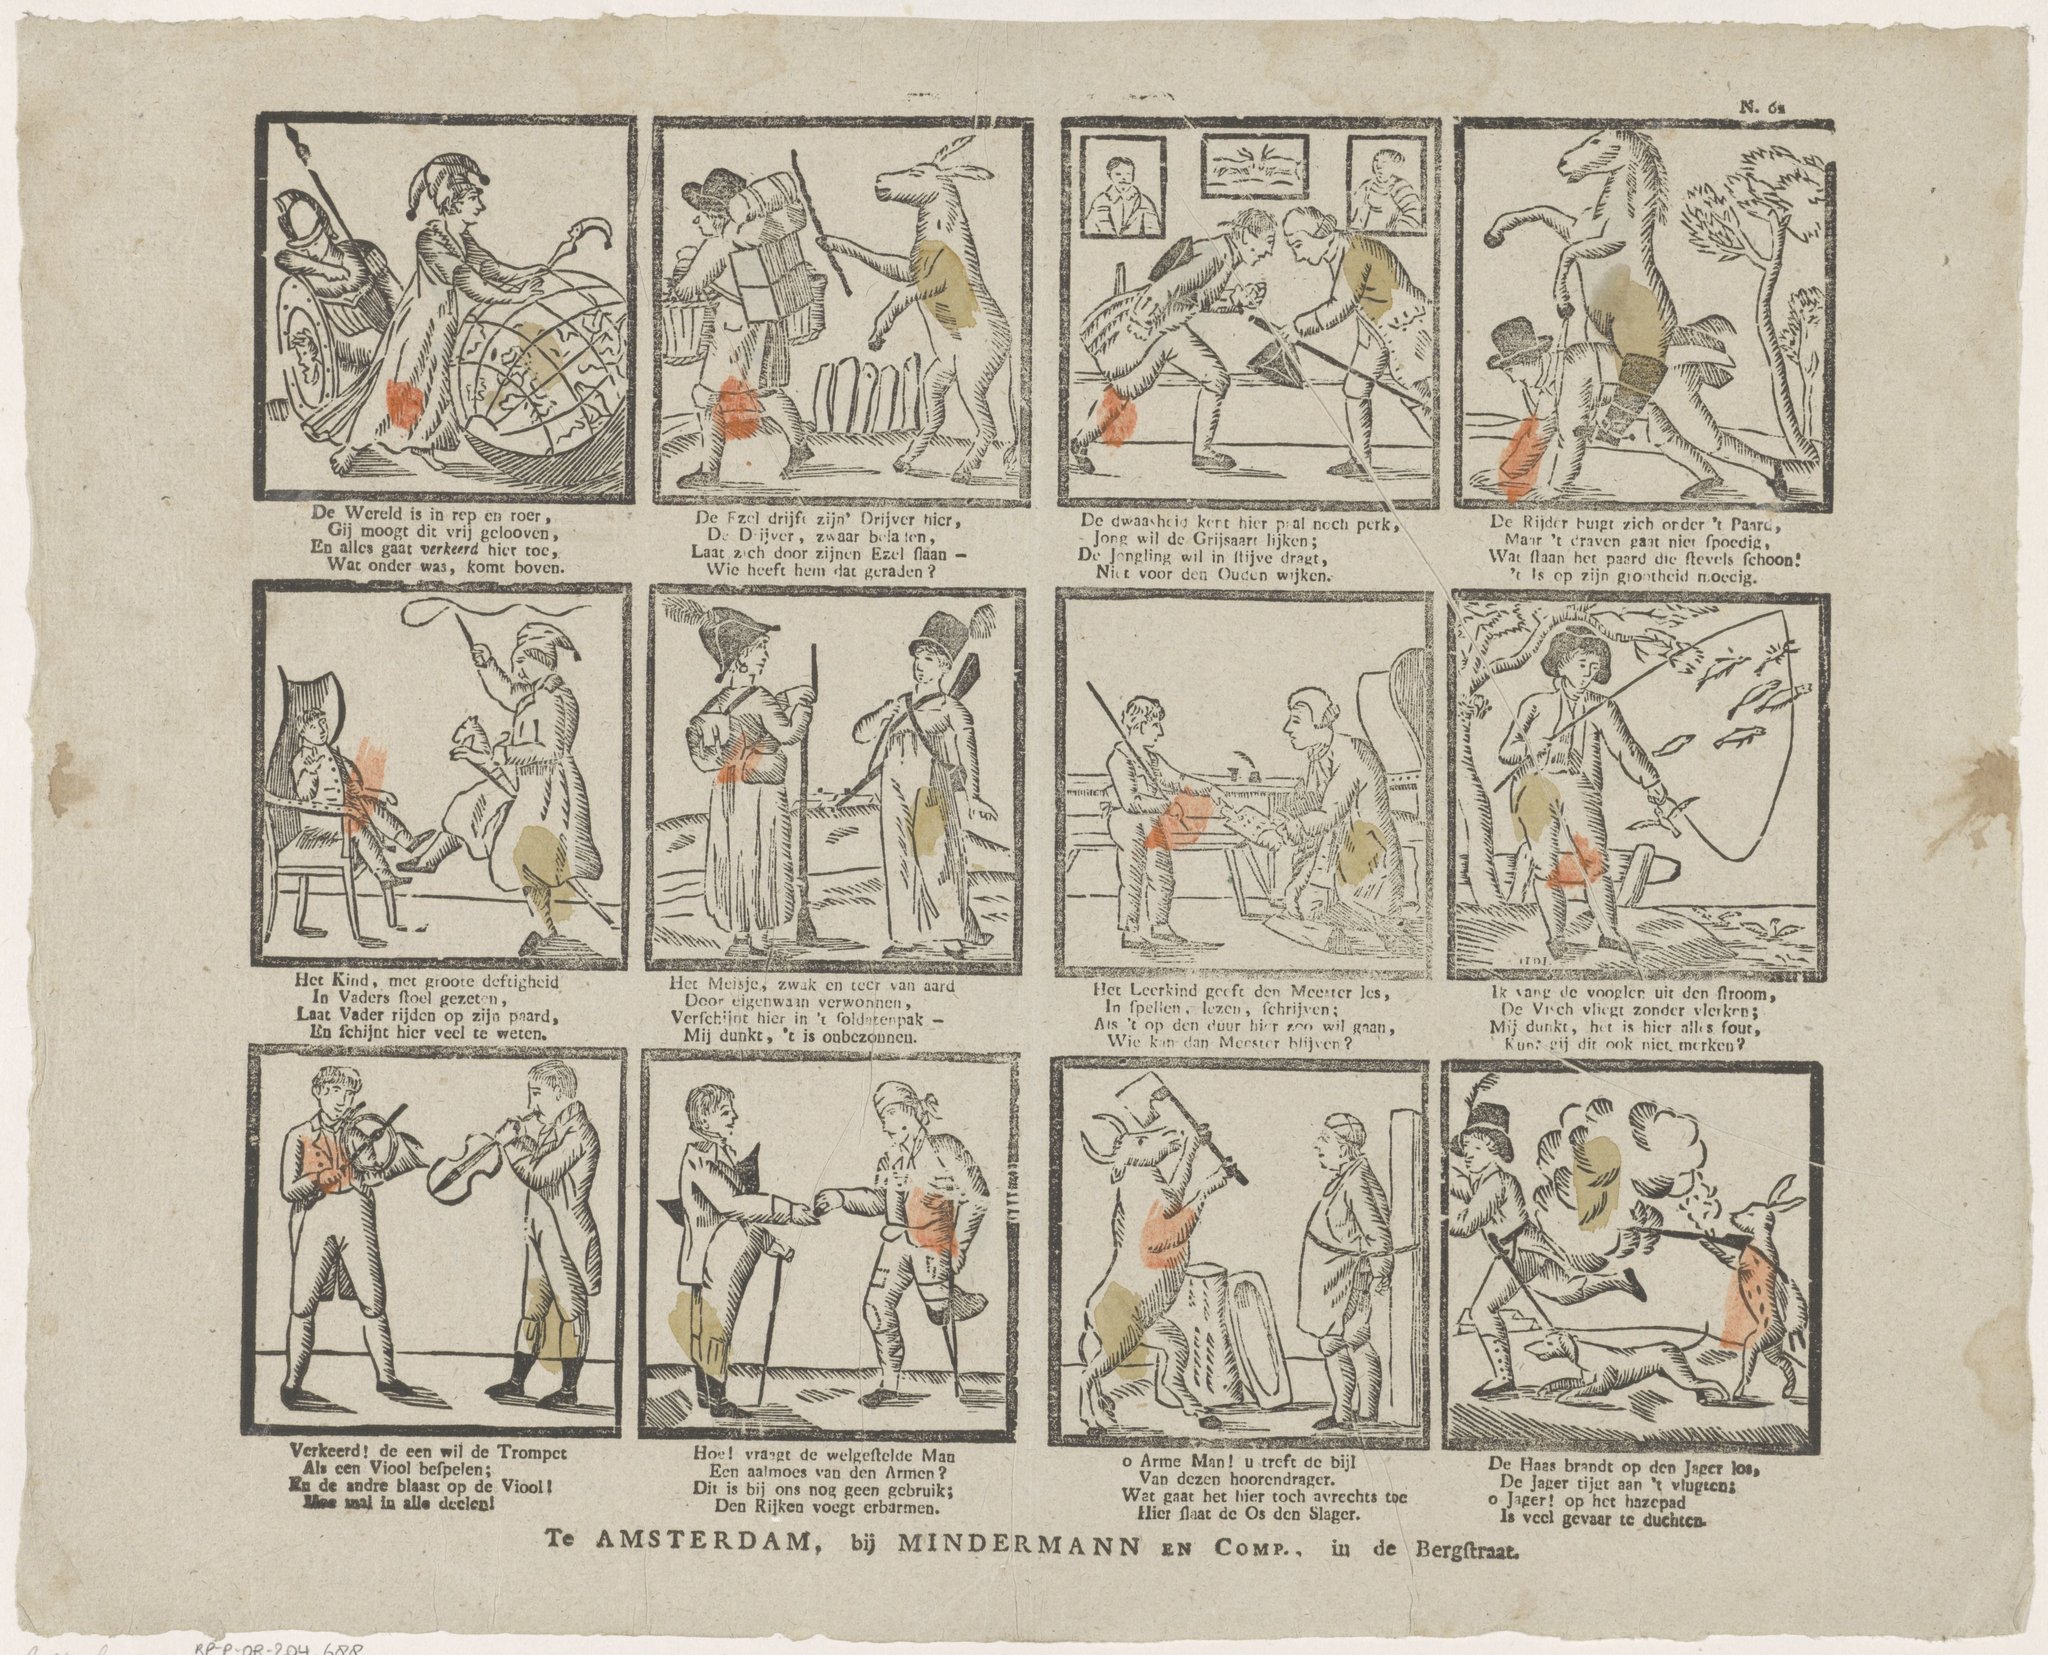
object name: print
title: Verkeerde wereld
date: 1822-1849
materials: paper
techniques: colour, letterpress printing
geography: netherlands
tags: 'mundus inversus', the reversed world, the topsy-turvy world, 'le monde bestourné', animals acting as human beings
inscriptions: collector's mark: Lugt 2760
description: Blad met 12 voorstellingen van de verkeerde wereld, waar onder andere dieren zich als mensen gedragen. Onder elke afbeelding een vierregelig vers. Genummerd rechtsboven: N. 62.